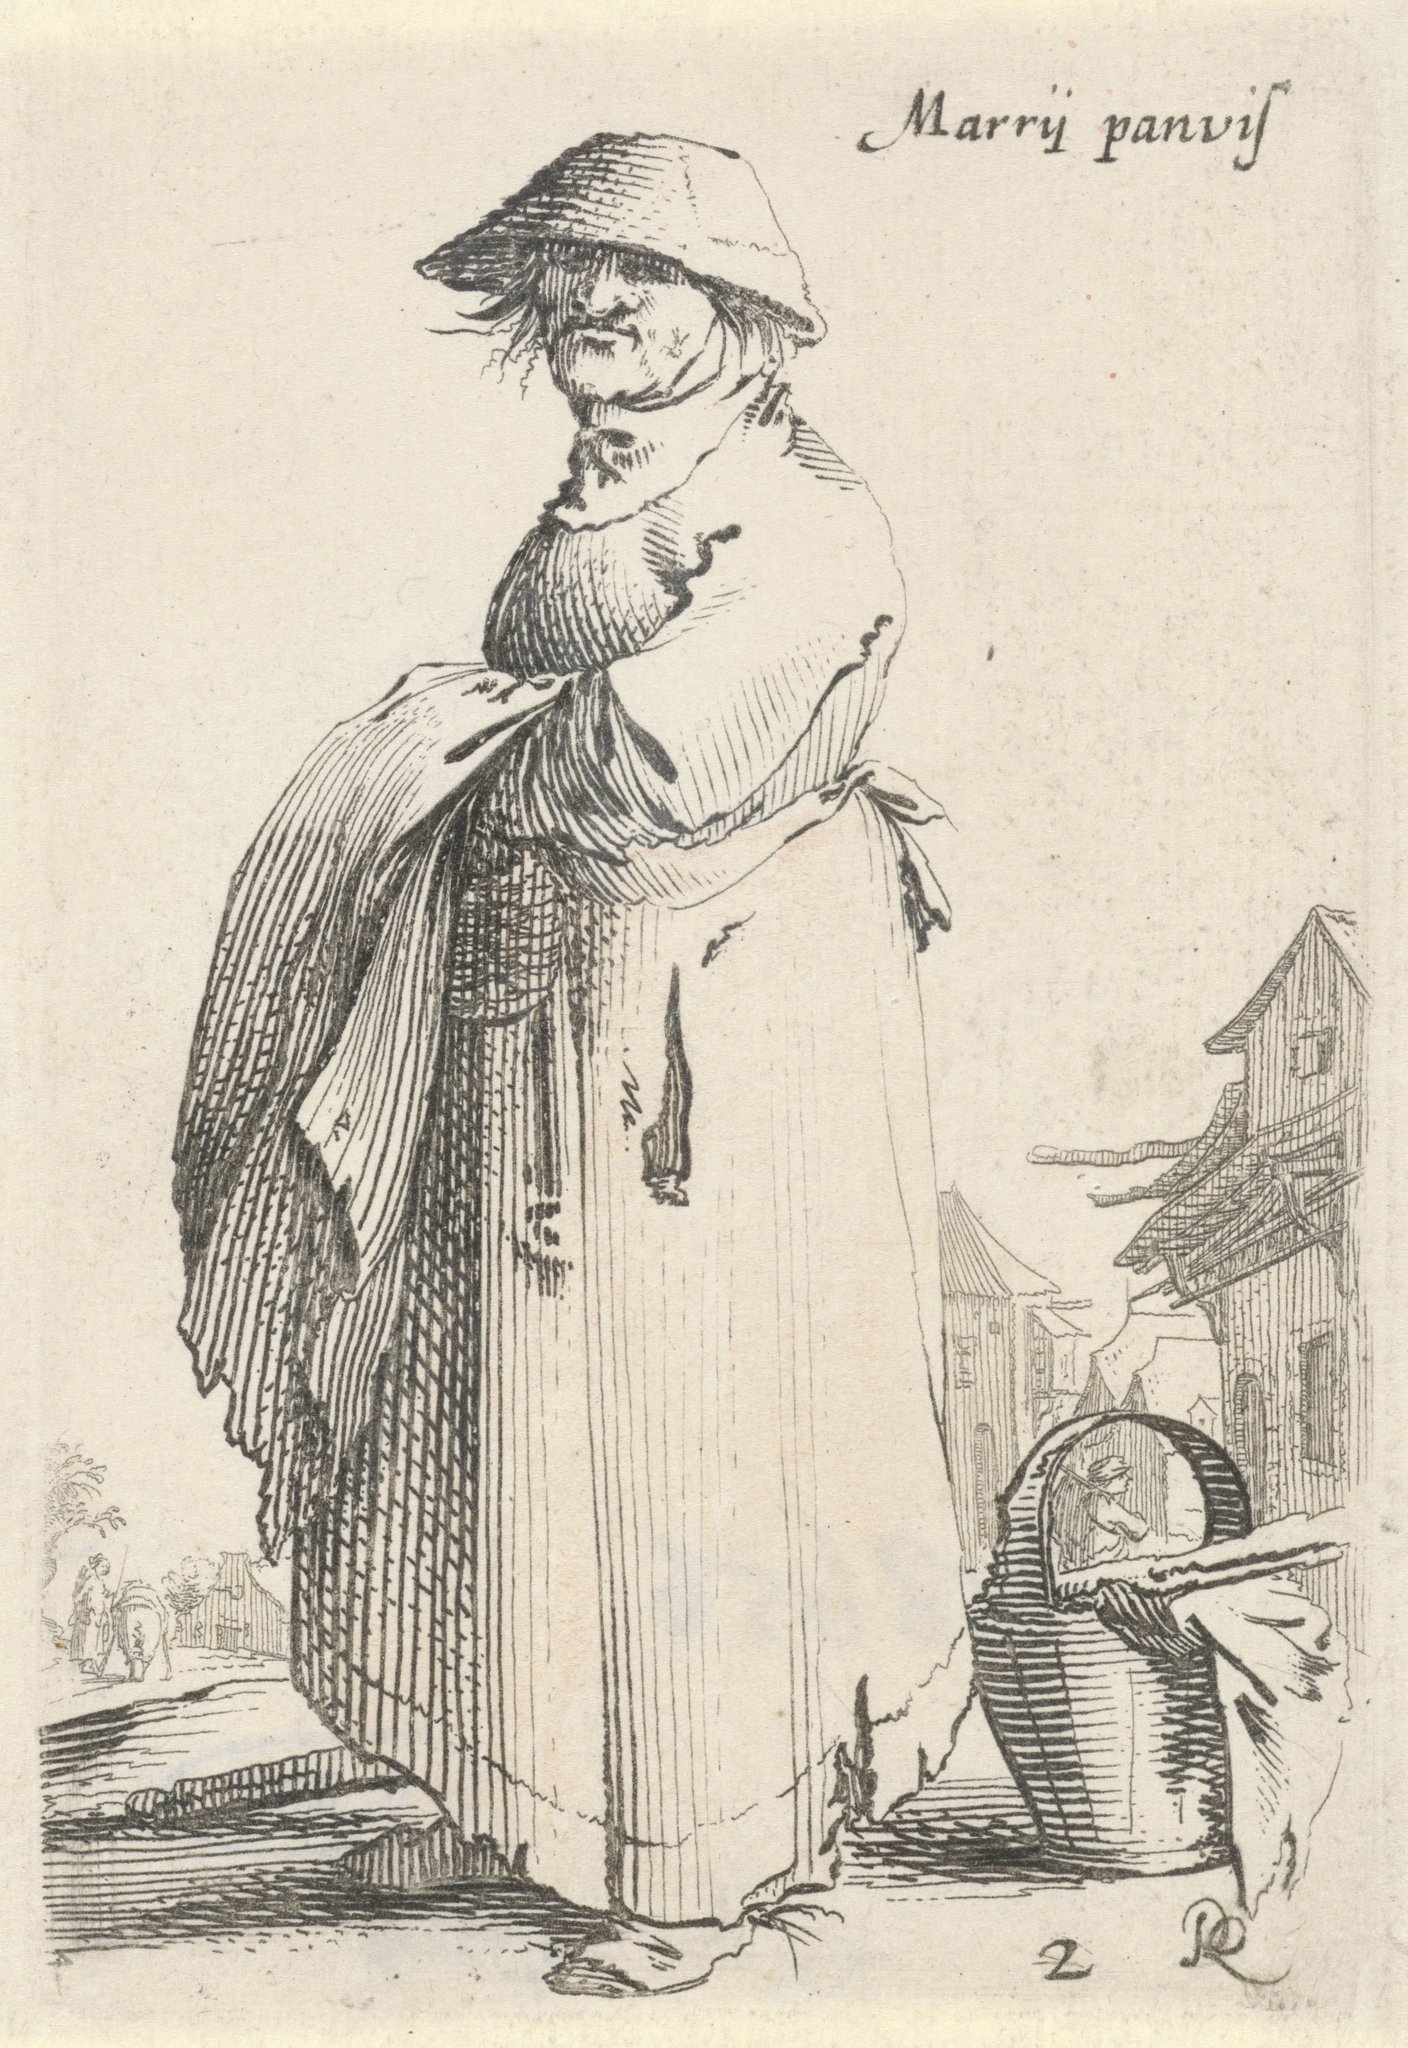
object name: print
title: T'Leven Der Boeren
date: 1630-1665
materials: paper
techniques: engraving, etching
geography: amsterdam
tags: wooden container: barrel, cask, bucket, farmers, textile fabric, cloth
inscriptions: collector's mark: Lugt 2228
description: De prent maakt deel uit van een twaalfdelige serie prenten met voorstellingen van boeren.